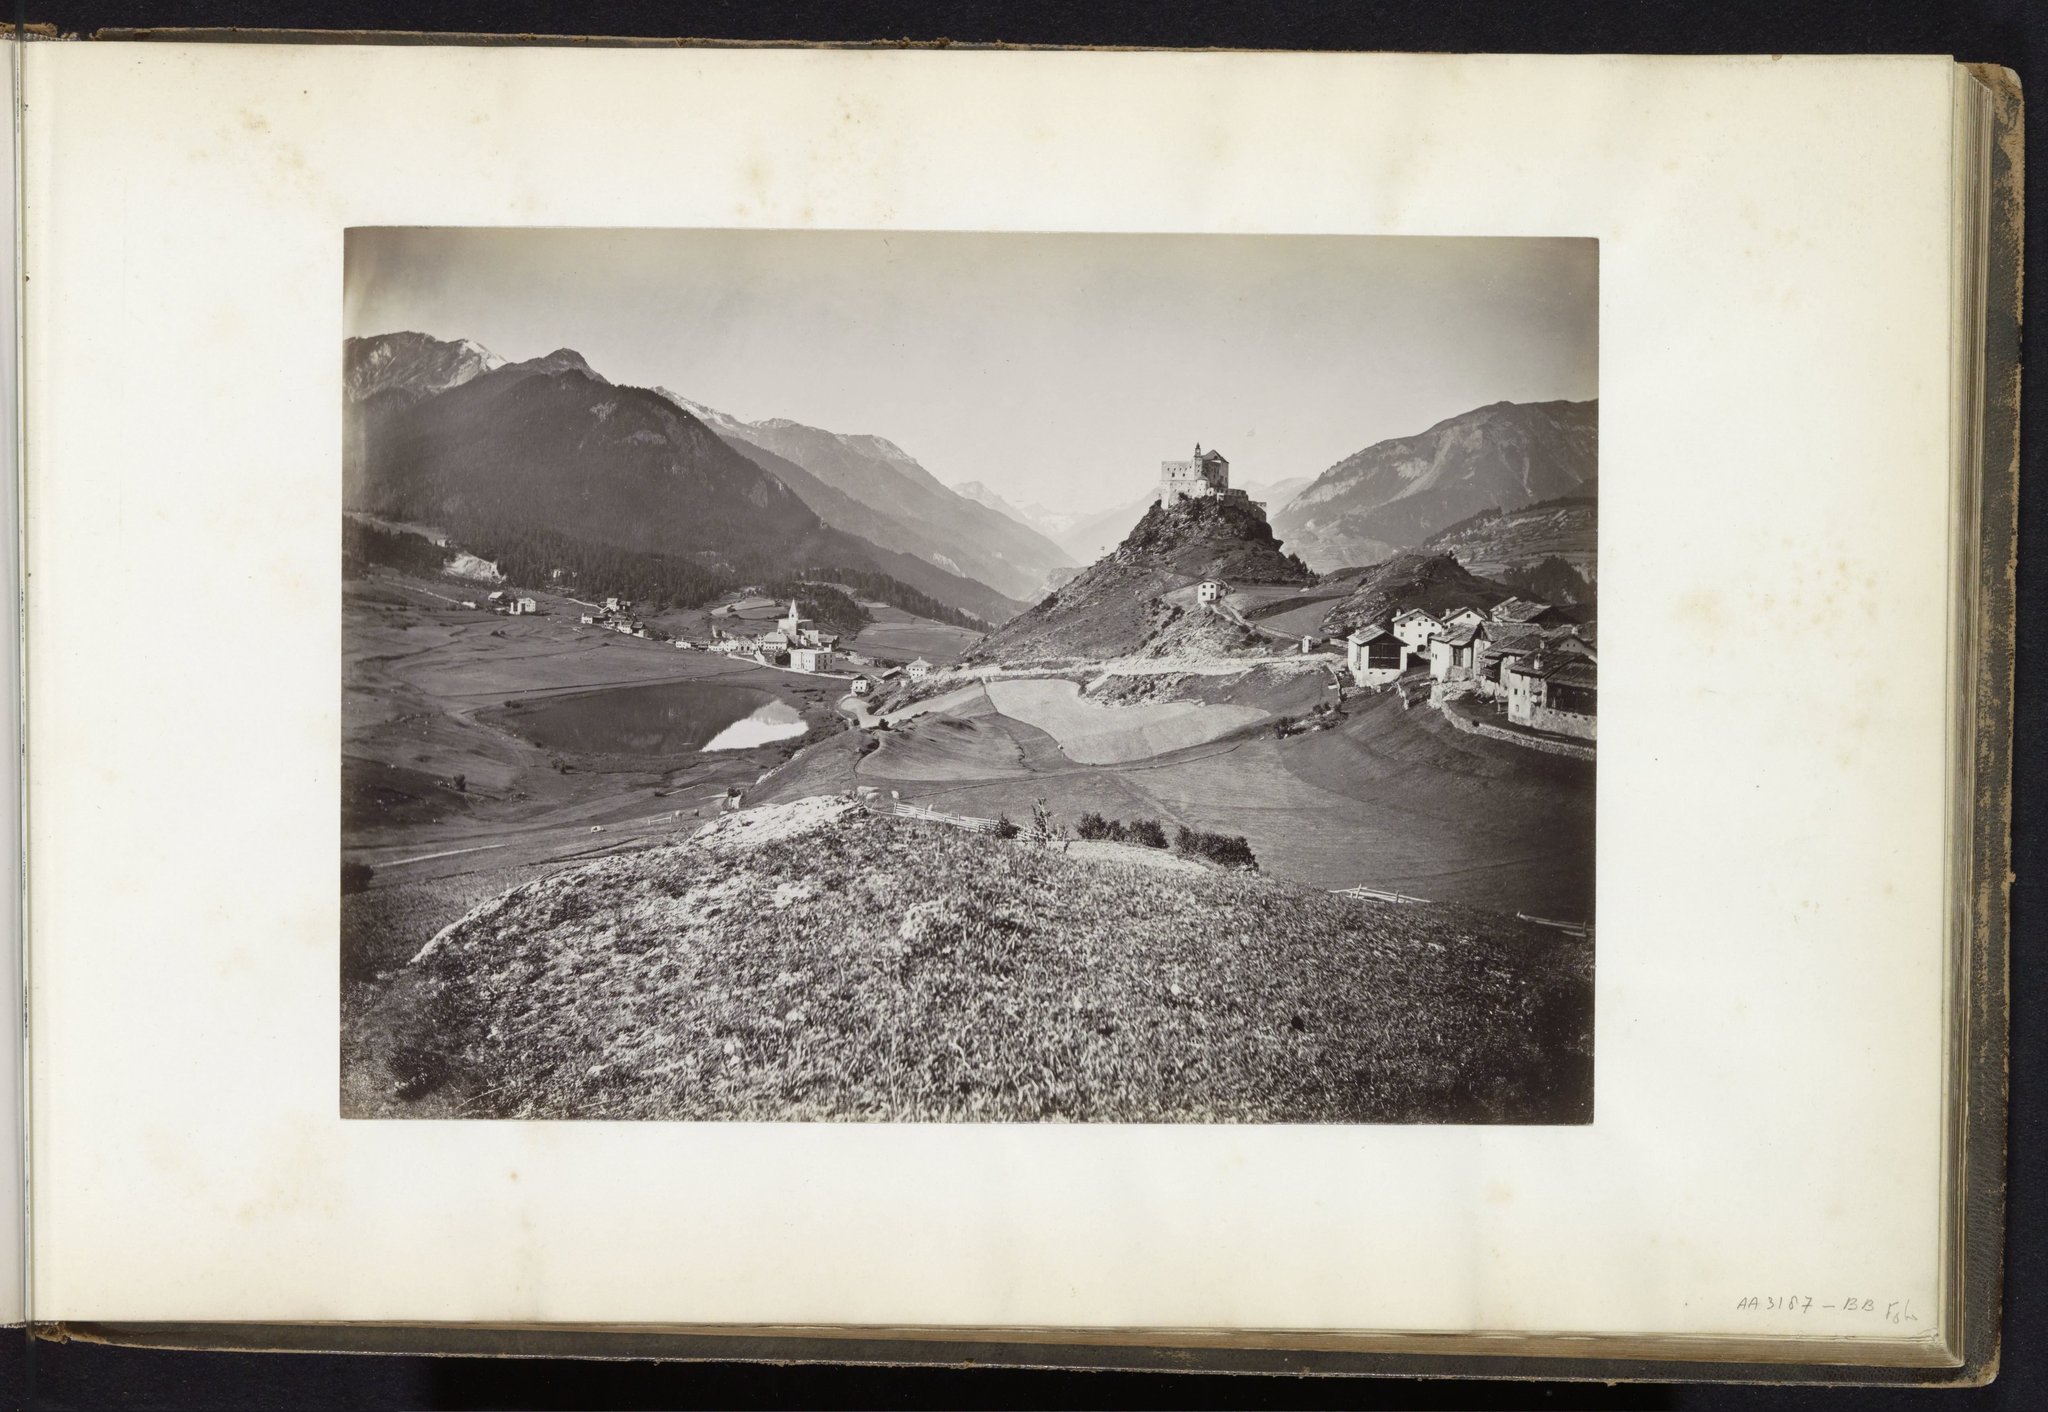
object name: photograph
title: Dal met dorp en een kasteel op een rots, vermoedelijk in de Alpen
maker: Anonymous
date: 1865-1875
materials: photographic support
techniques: albumen print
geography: alps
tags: prospect of village, silhouette of village, dale, valley, castle, mountains (+ landscape with figures, staffage)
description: Onderdeel van Reisalbum met opnames van bezienswaardigheden in India, Duitsland, Zwitserland en Frankrijk.